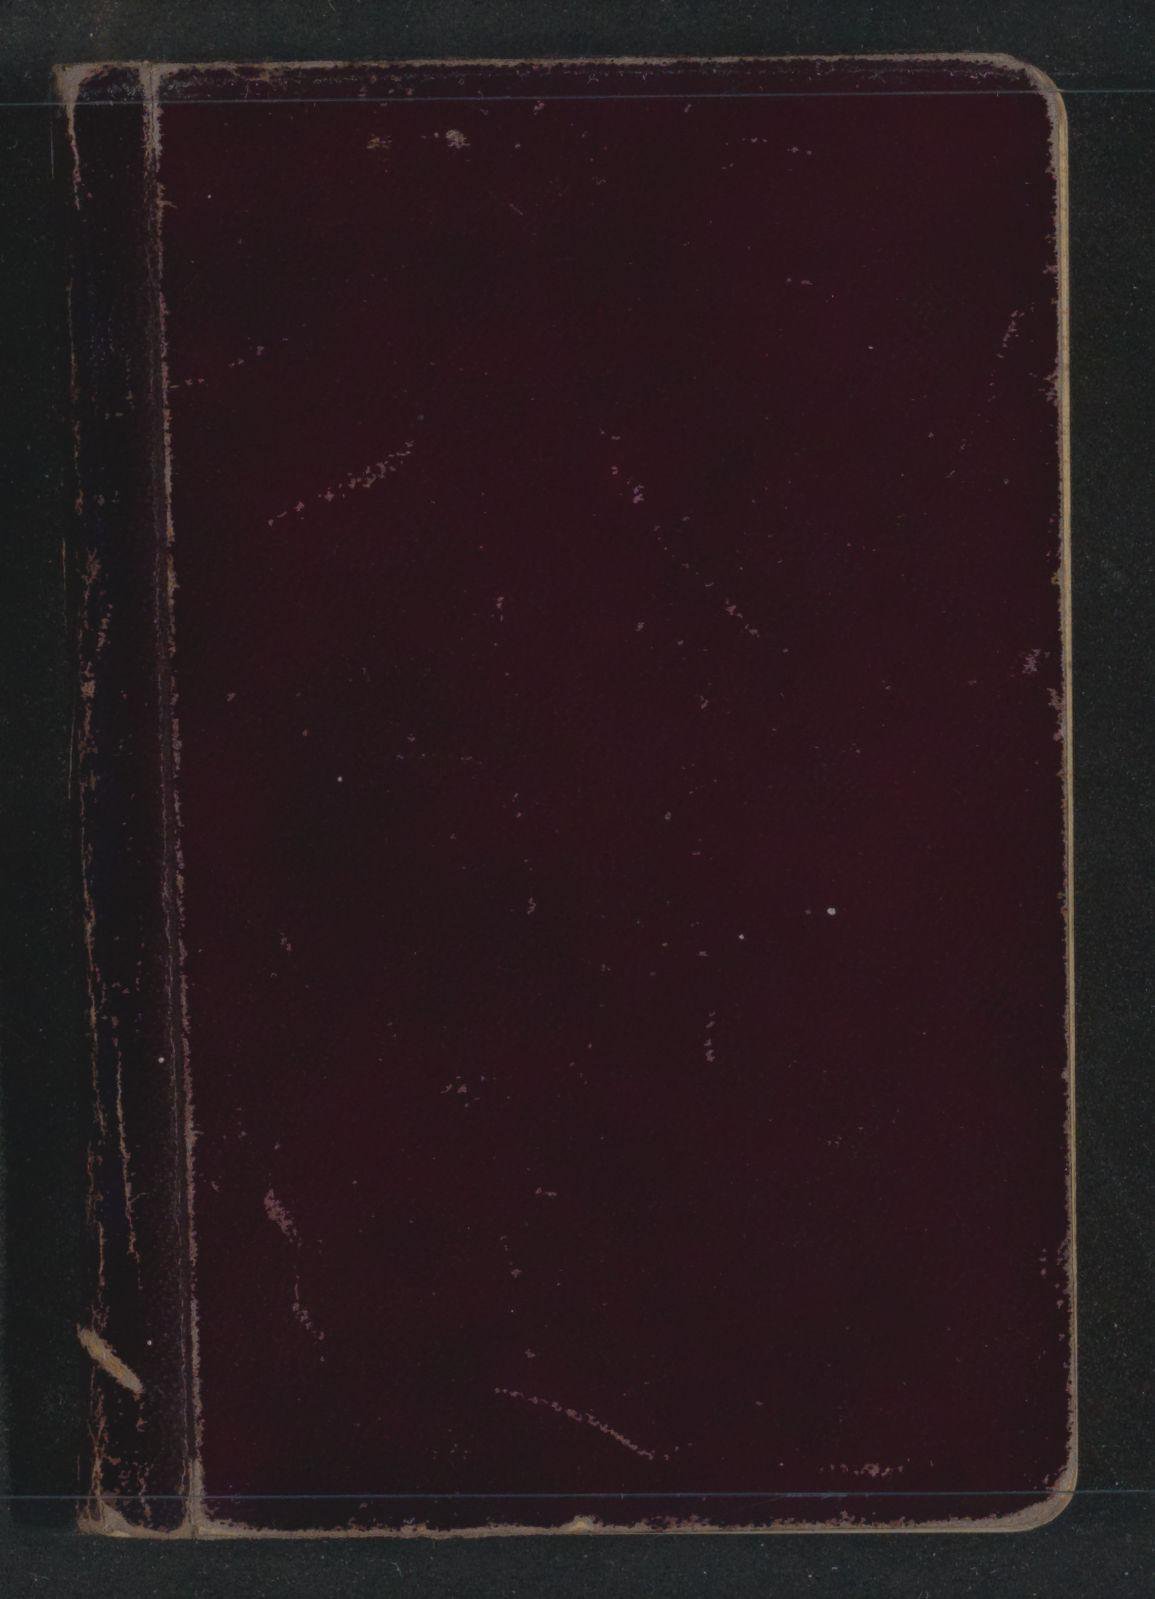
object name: sketchbook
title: Schetsboek met 91 bladen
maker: alexander shilling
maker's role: draughtsman, print maker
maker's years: 1859-1937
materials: cardboard, chalk, ink, leather, paper, pencil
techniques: pen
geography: woensdrecht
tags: prospect of village, silhouette of village, sailing-ship, sailing-boat, windmill in landscape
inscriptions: annotation: ‘Wv Hem[...]s/ orga[...]/ vrije leive [sic]/ vrouwen/ Kerk/ July 11/10’, factory mark: ‘SIZE OF THIS SKETCH BOOK, 5 X 3 1/4./ DIMENSIONS DE L'ALBUM} 13 X 8.5/ GRÖSSE DIESES SKIZZENBUCHES} CM.’, factory mark: ‘THE/ BLACK/ & WHITE/ SKETCH/ BOOK/ Winsor and Newton LtD/ LONDON/ MADE/ IN THE/ FOLLOWIG/ SIZES/ 3 1/2 x 3/ 5 x 3 1/4 8 x 5/ 7 1/4 x 4 1/2 10 x 8’, date and inscription: ‘Alexander Shilling. (Schilling)/ ha[...] schetsen uit/ Woensdrecht/ vanaf 5 Juli 1909/ tot 12 Aug. 1910’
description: Schetsboek bestaande uit 91 bladen met landschappen met molens, water en bebouwing, zeilboten en gezichten op Woensdrecht.